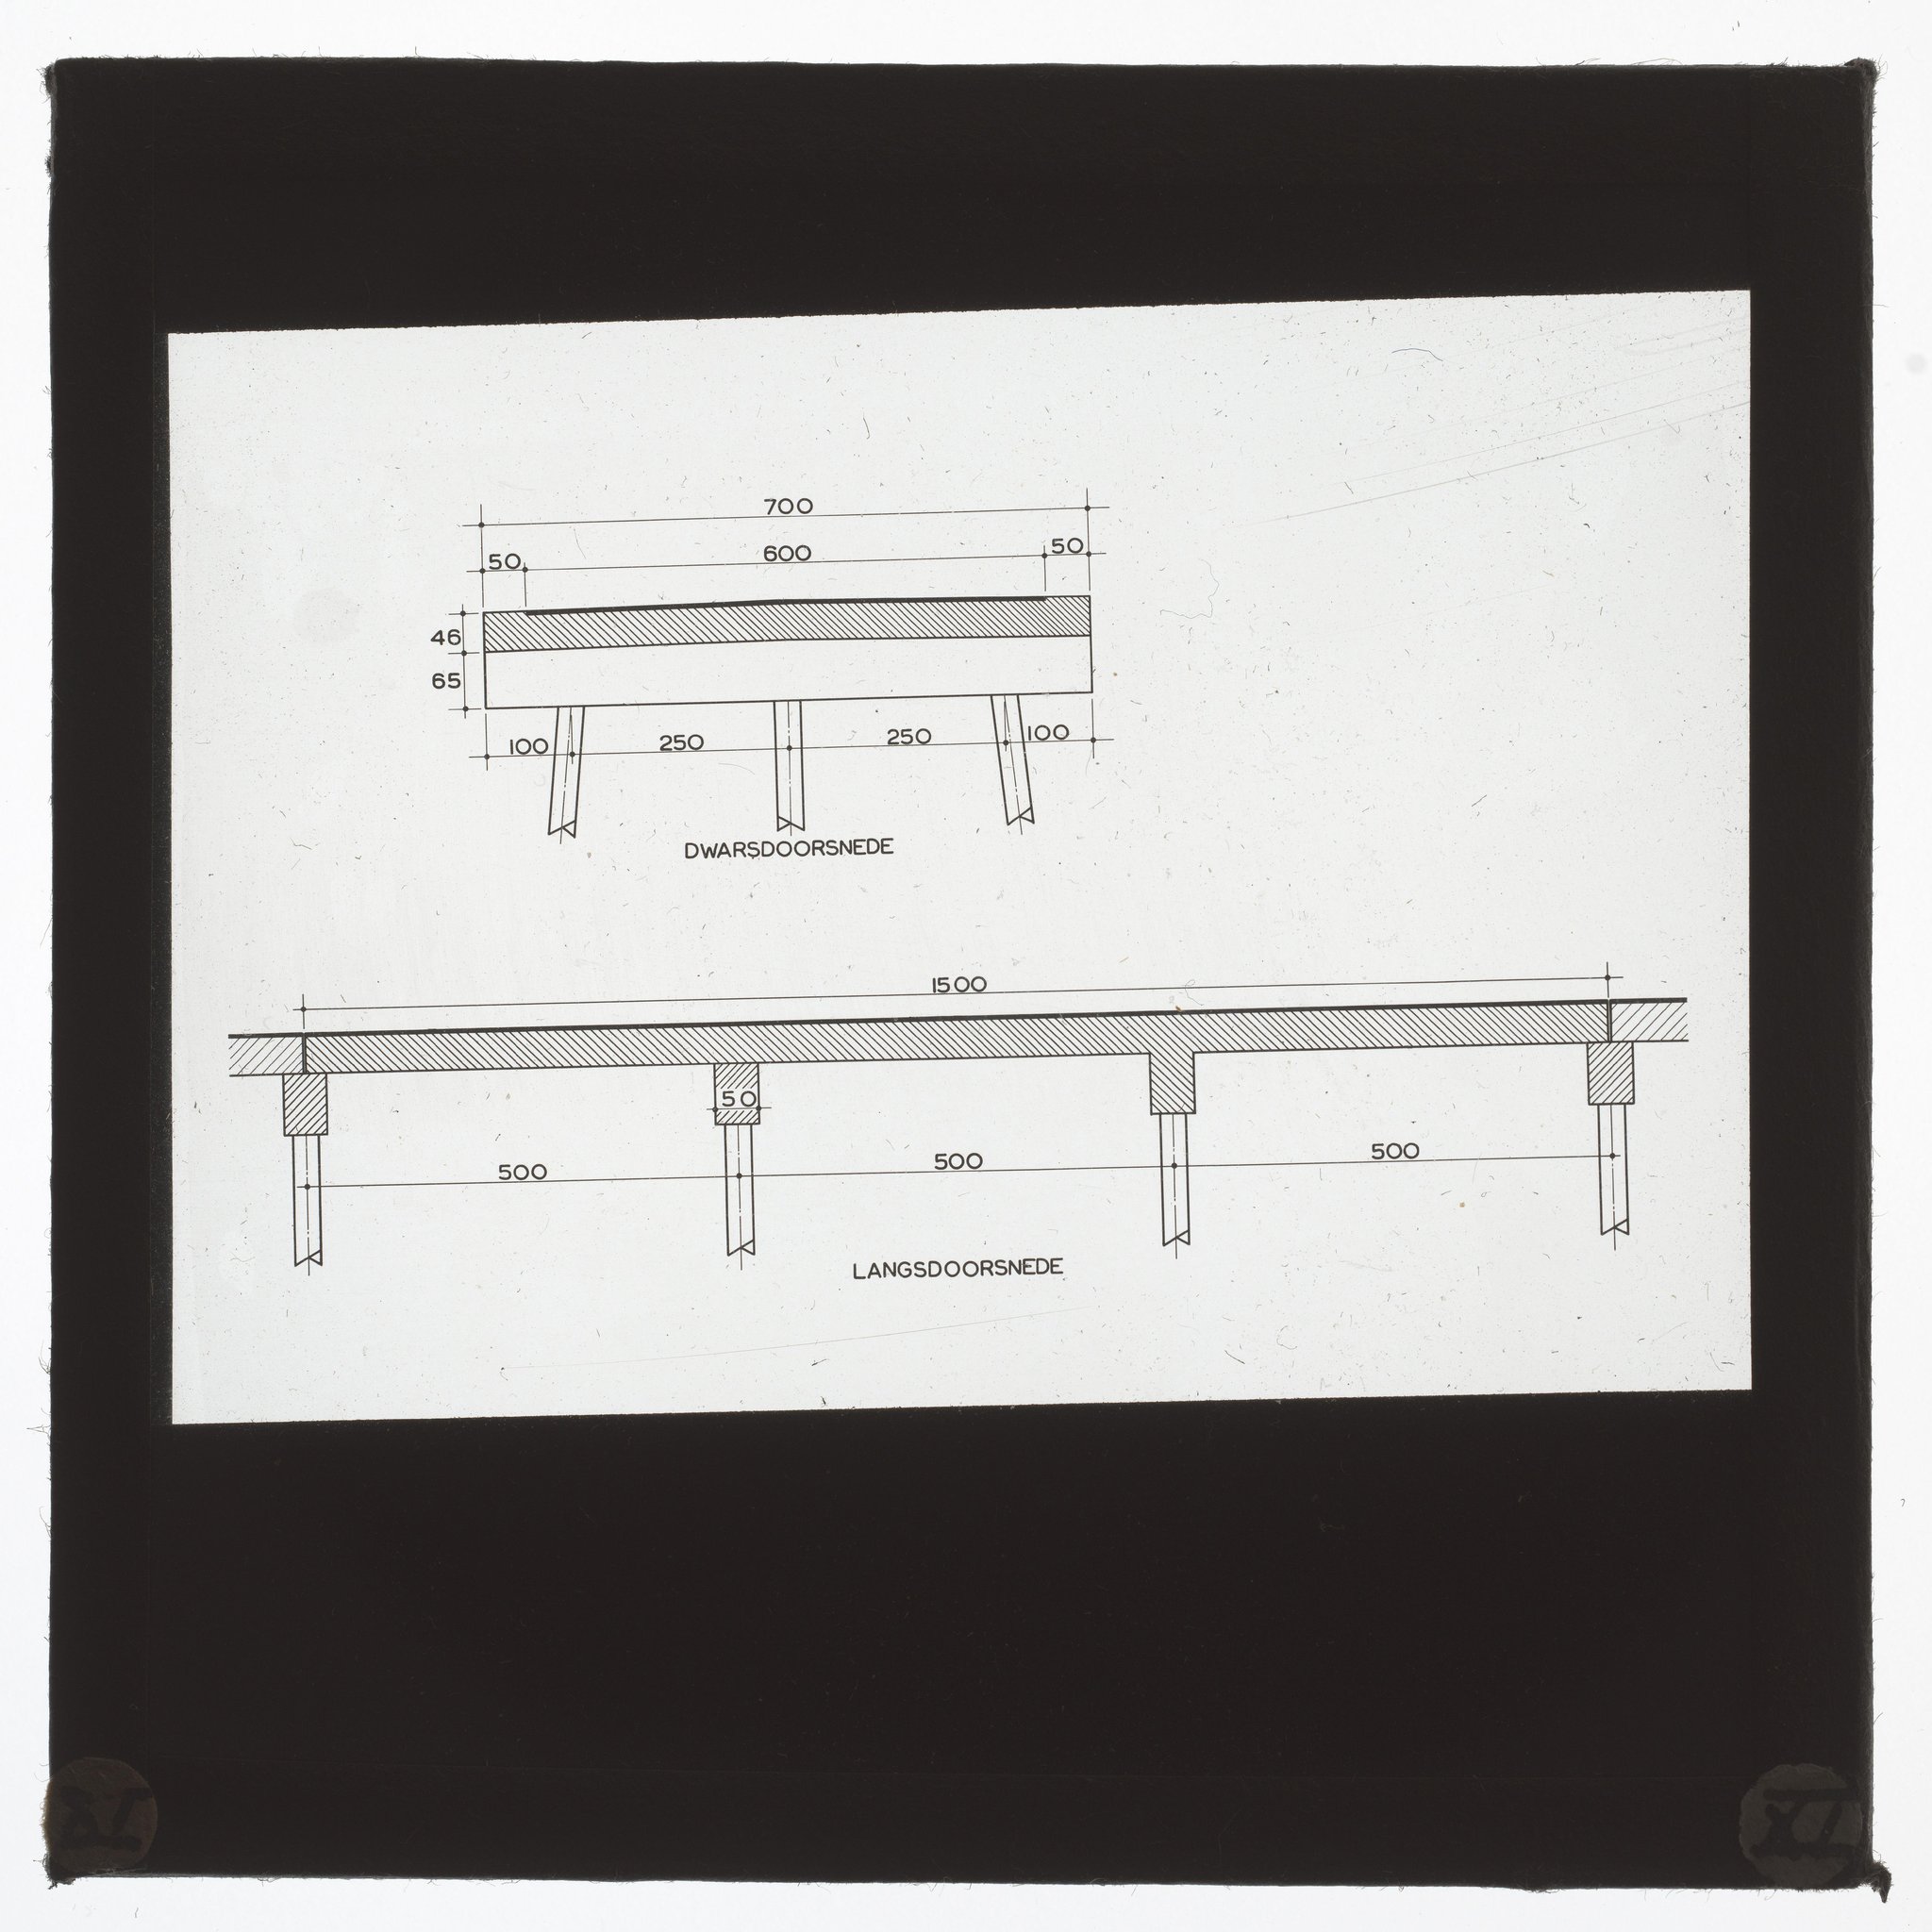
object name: lantern slide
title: Twee doorsneden van een weg in Zuid-Holland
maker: Anonymous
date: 1956-1960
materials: glass, paper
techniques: printing block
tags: statistic diagram, graph; pictorial chart, etc., public road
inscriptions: number: ‘XI’